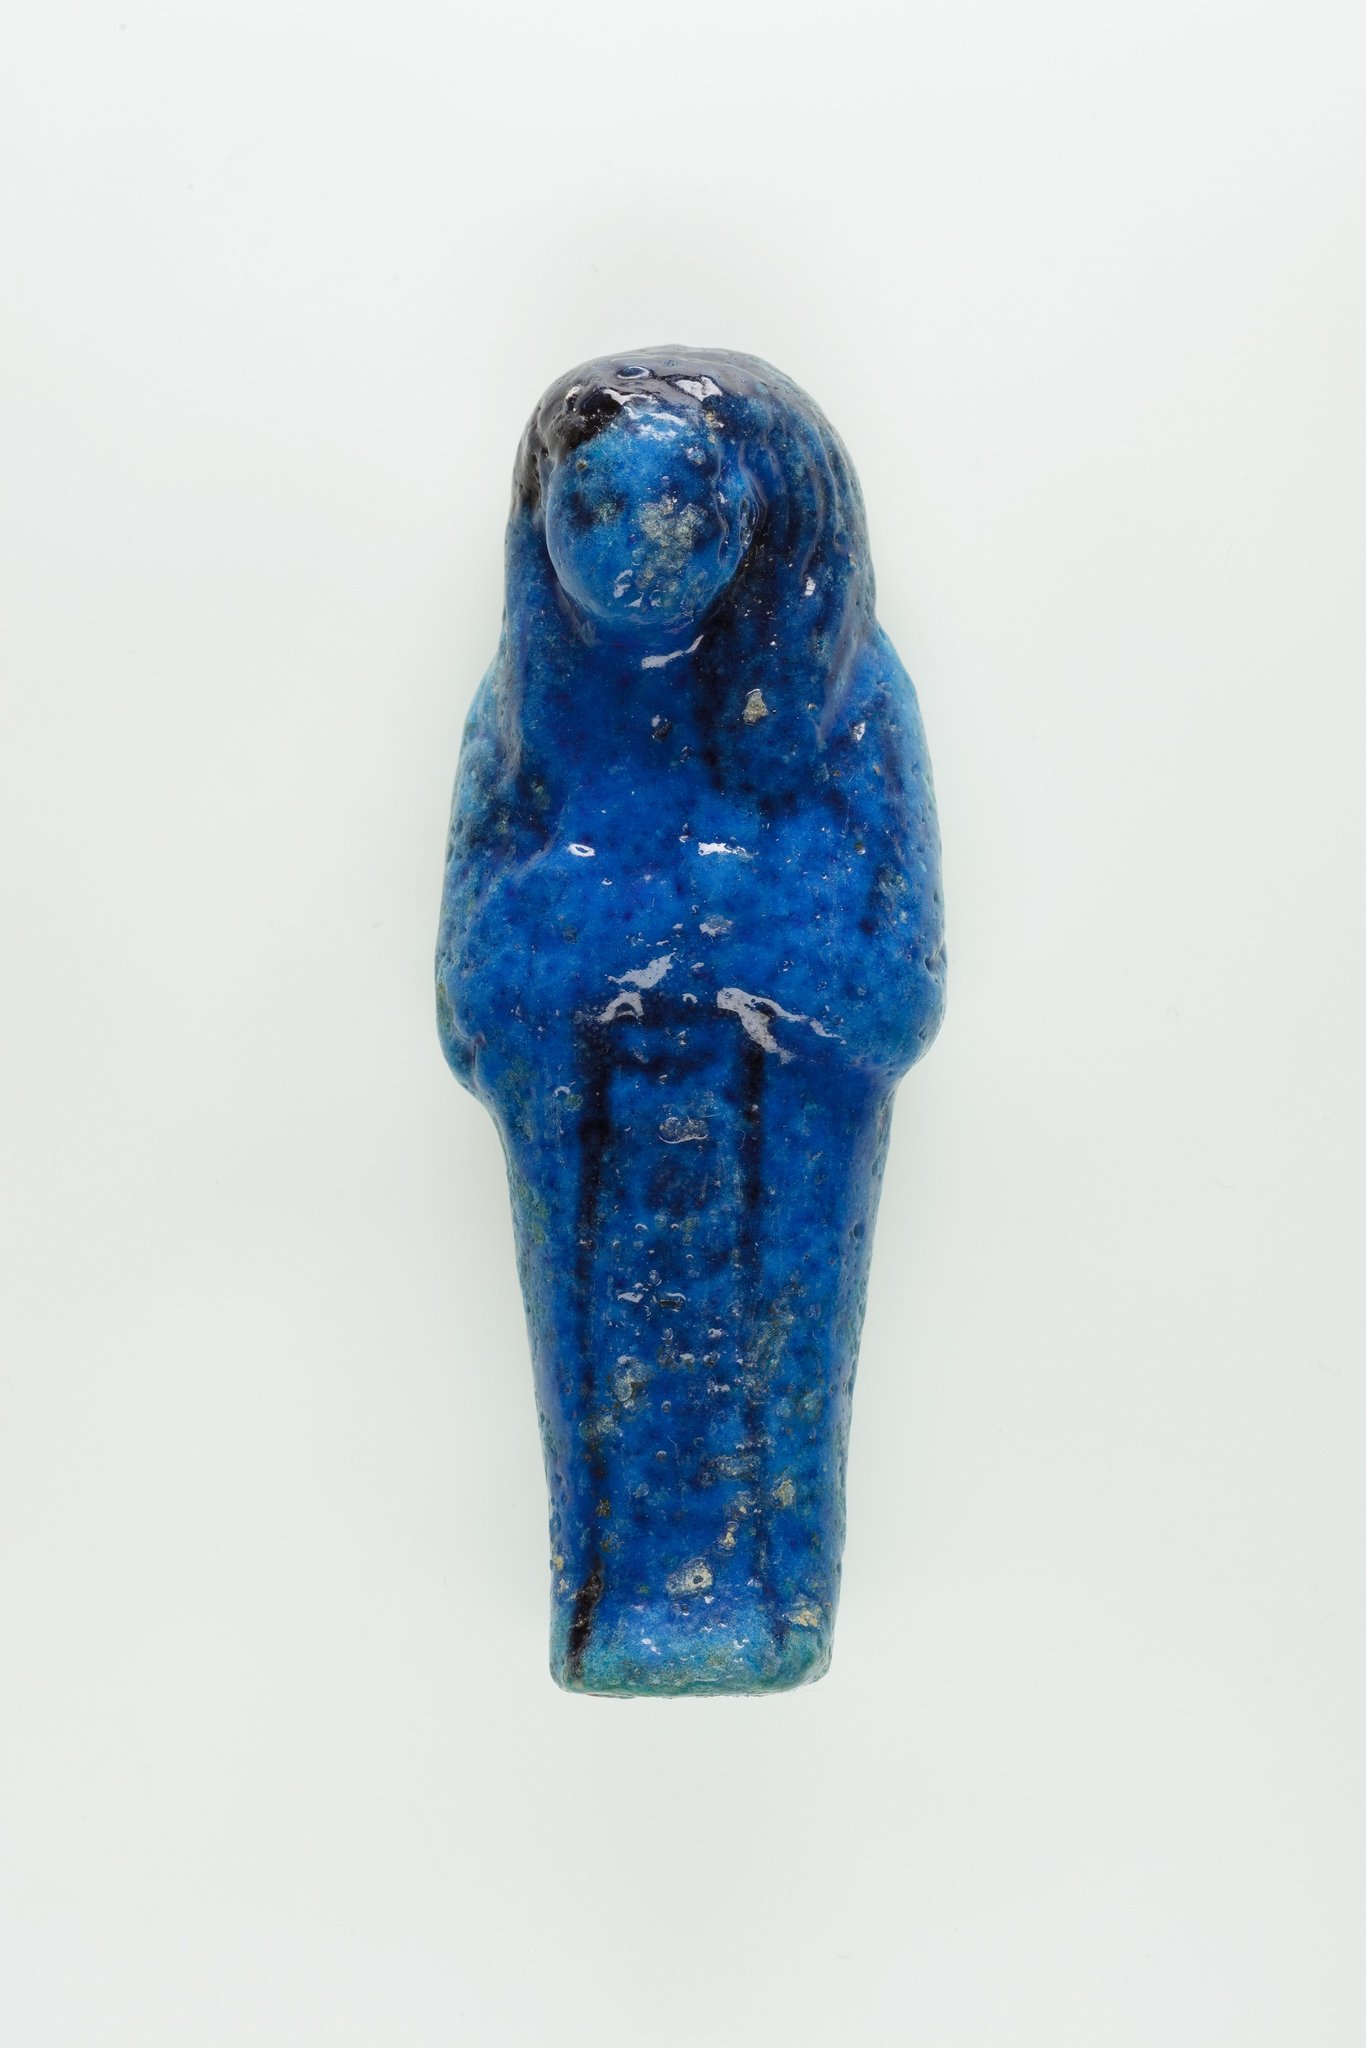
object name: shabti, worker, nauny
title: Worker Shabti of Nauny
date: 1050 BCE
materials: faience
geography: egypt